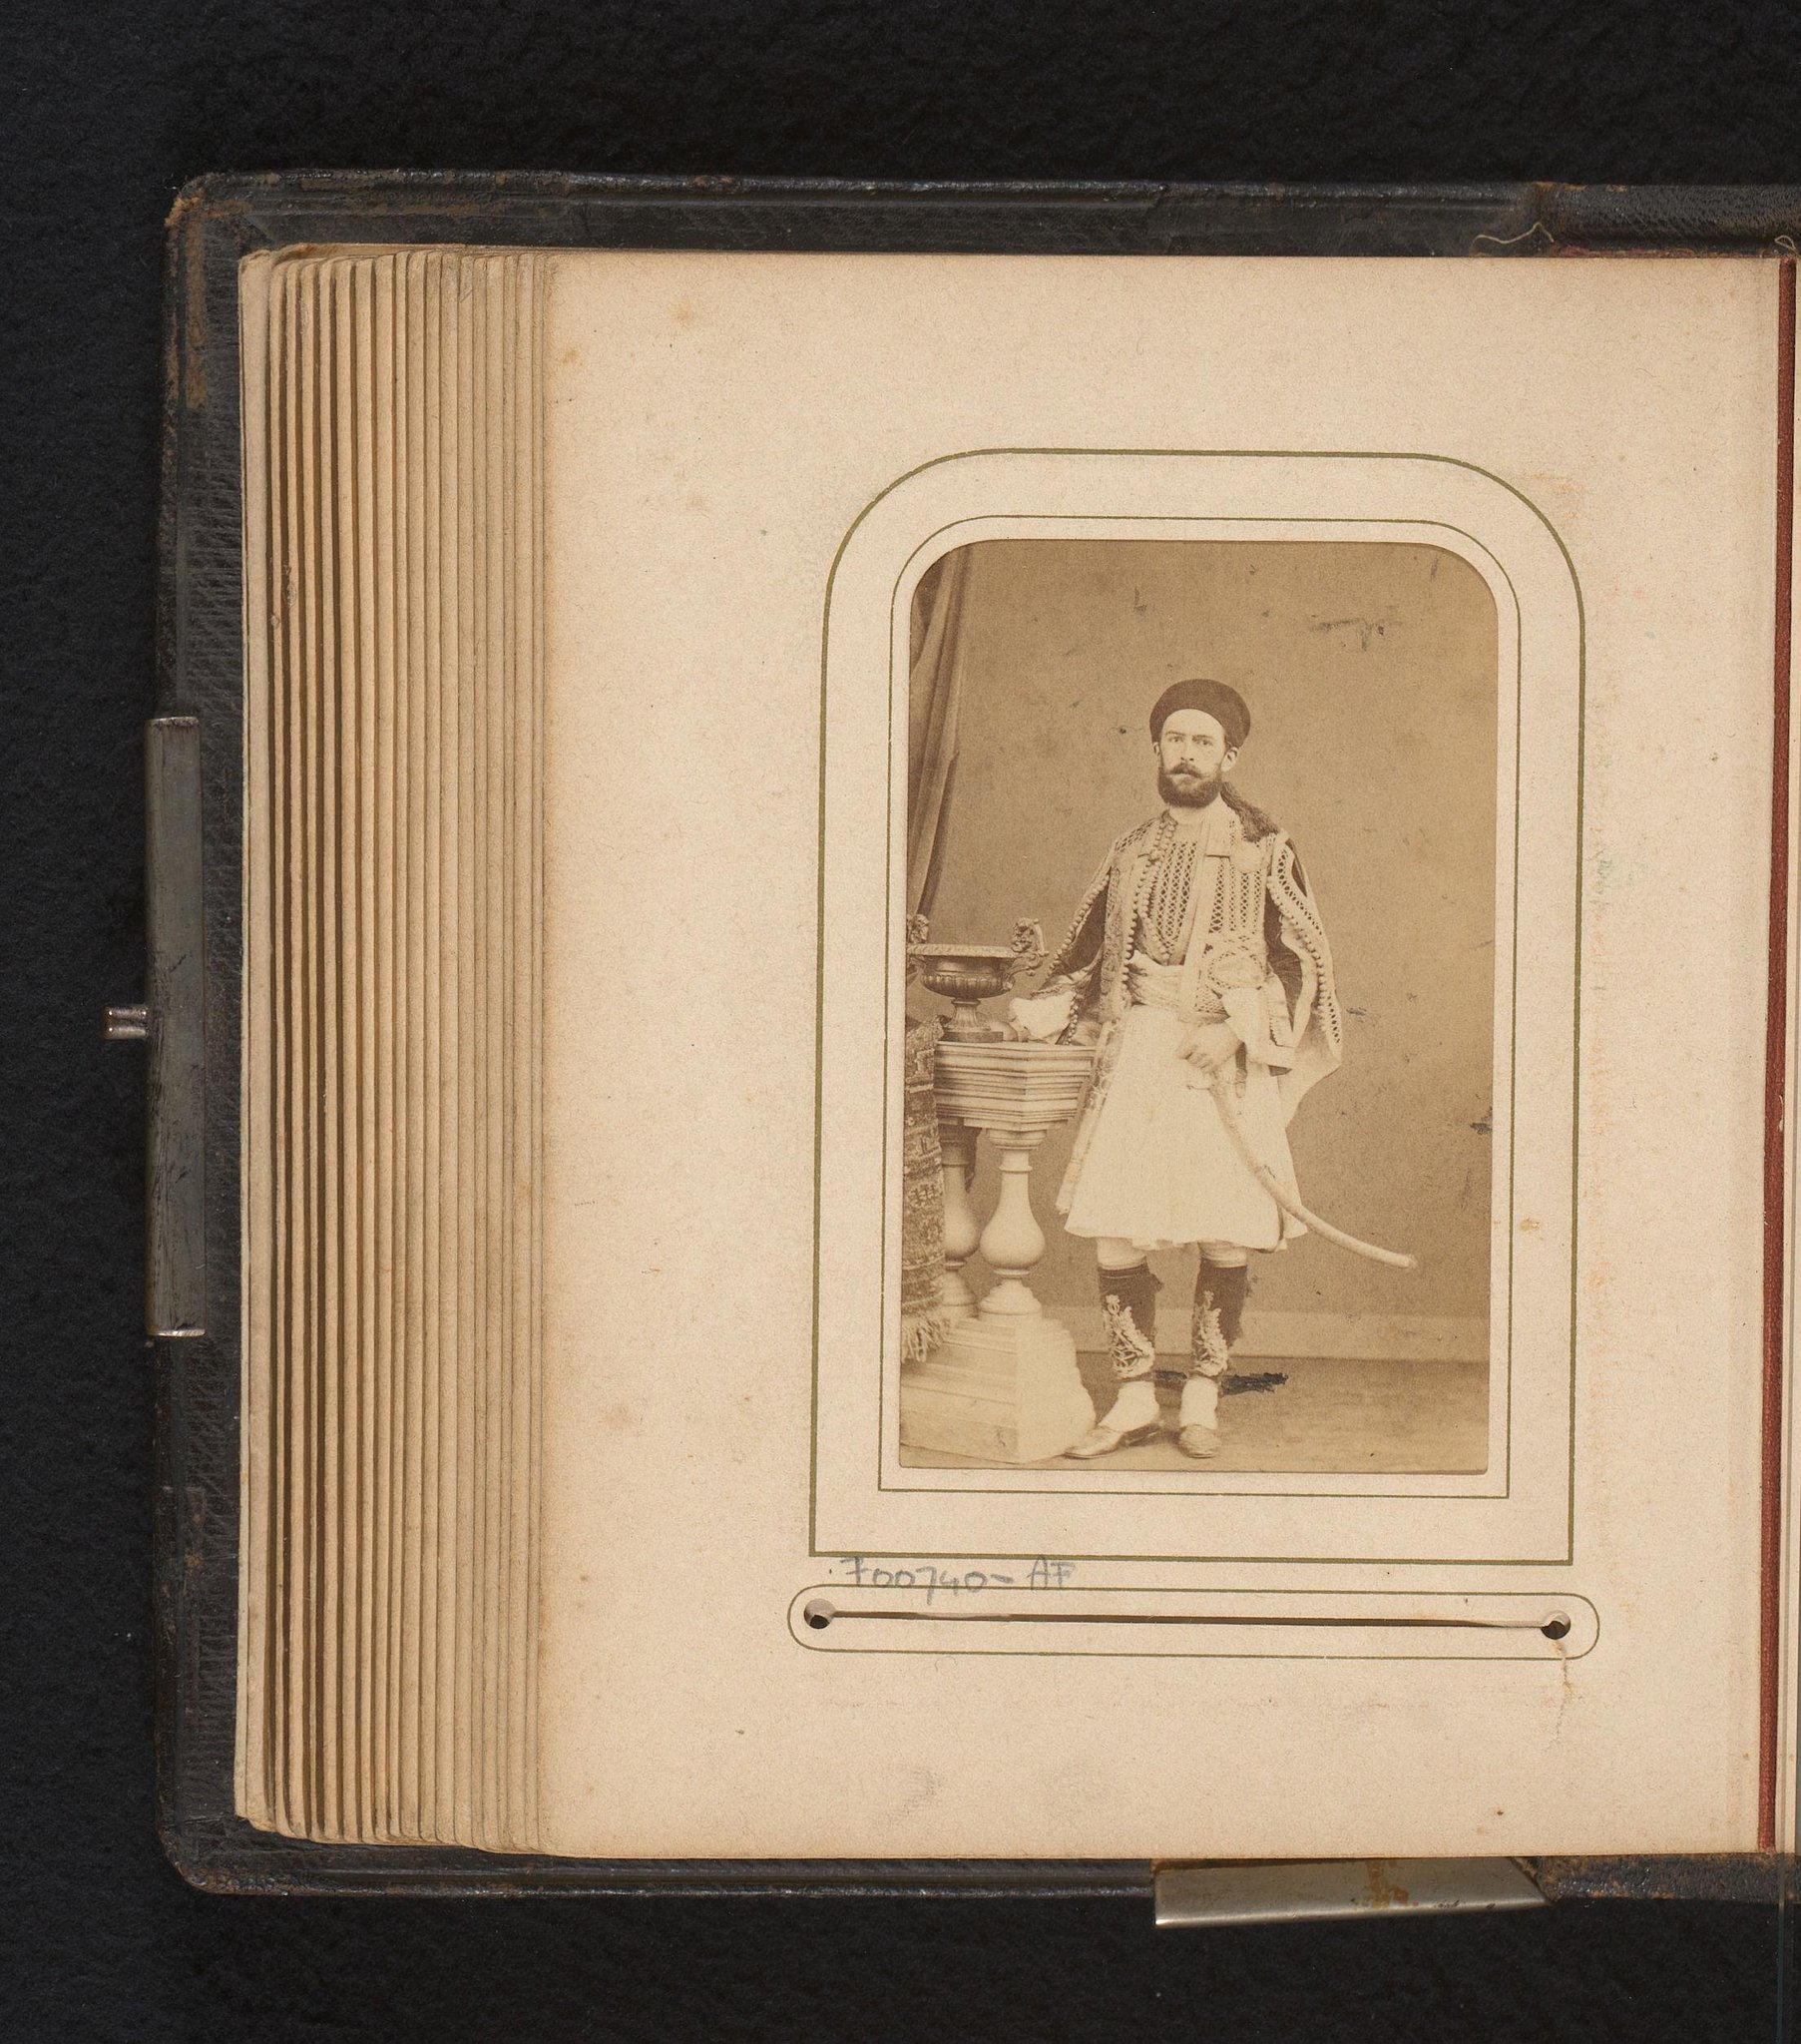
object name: album leaf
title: Portret van een man, vermoedelijk uit de Balkan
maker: maurits verveer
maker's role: painter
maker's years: 1817-1903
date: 1861-1883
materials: cardboard, photographic support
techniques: albumen print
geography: the hague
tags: historical persons, folk costume, regional costume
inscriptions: inscription: ‘M. Verveer/ Photographie/ 52, Zeestraat 52/ vis a vis du Willemspark/ La Haye’